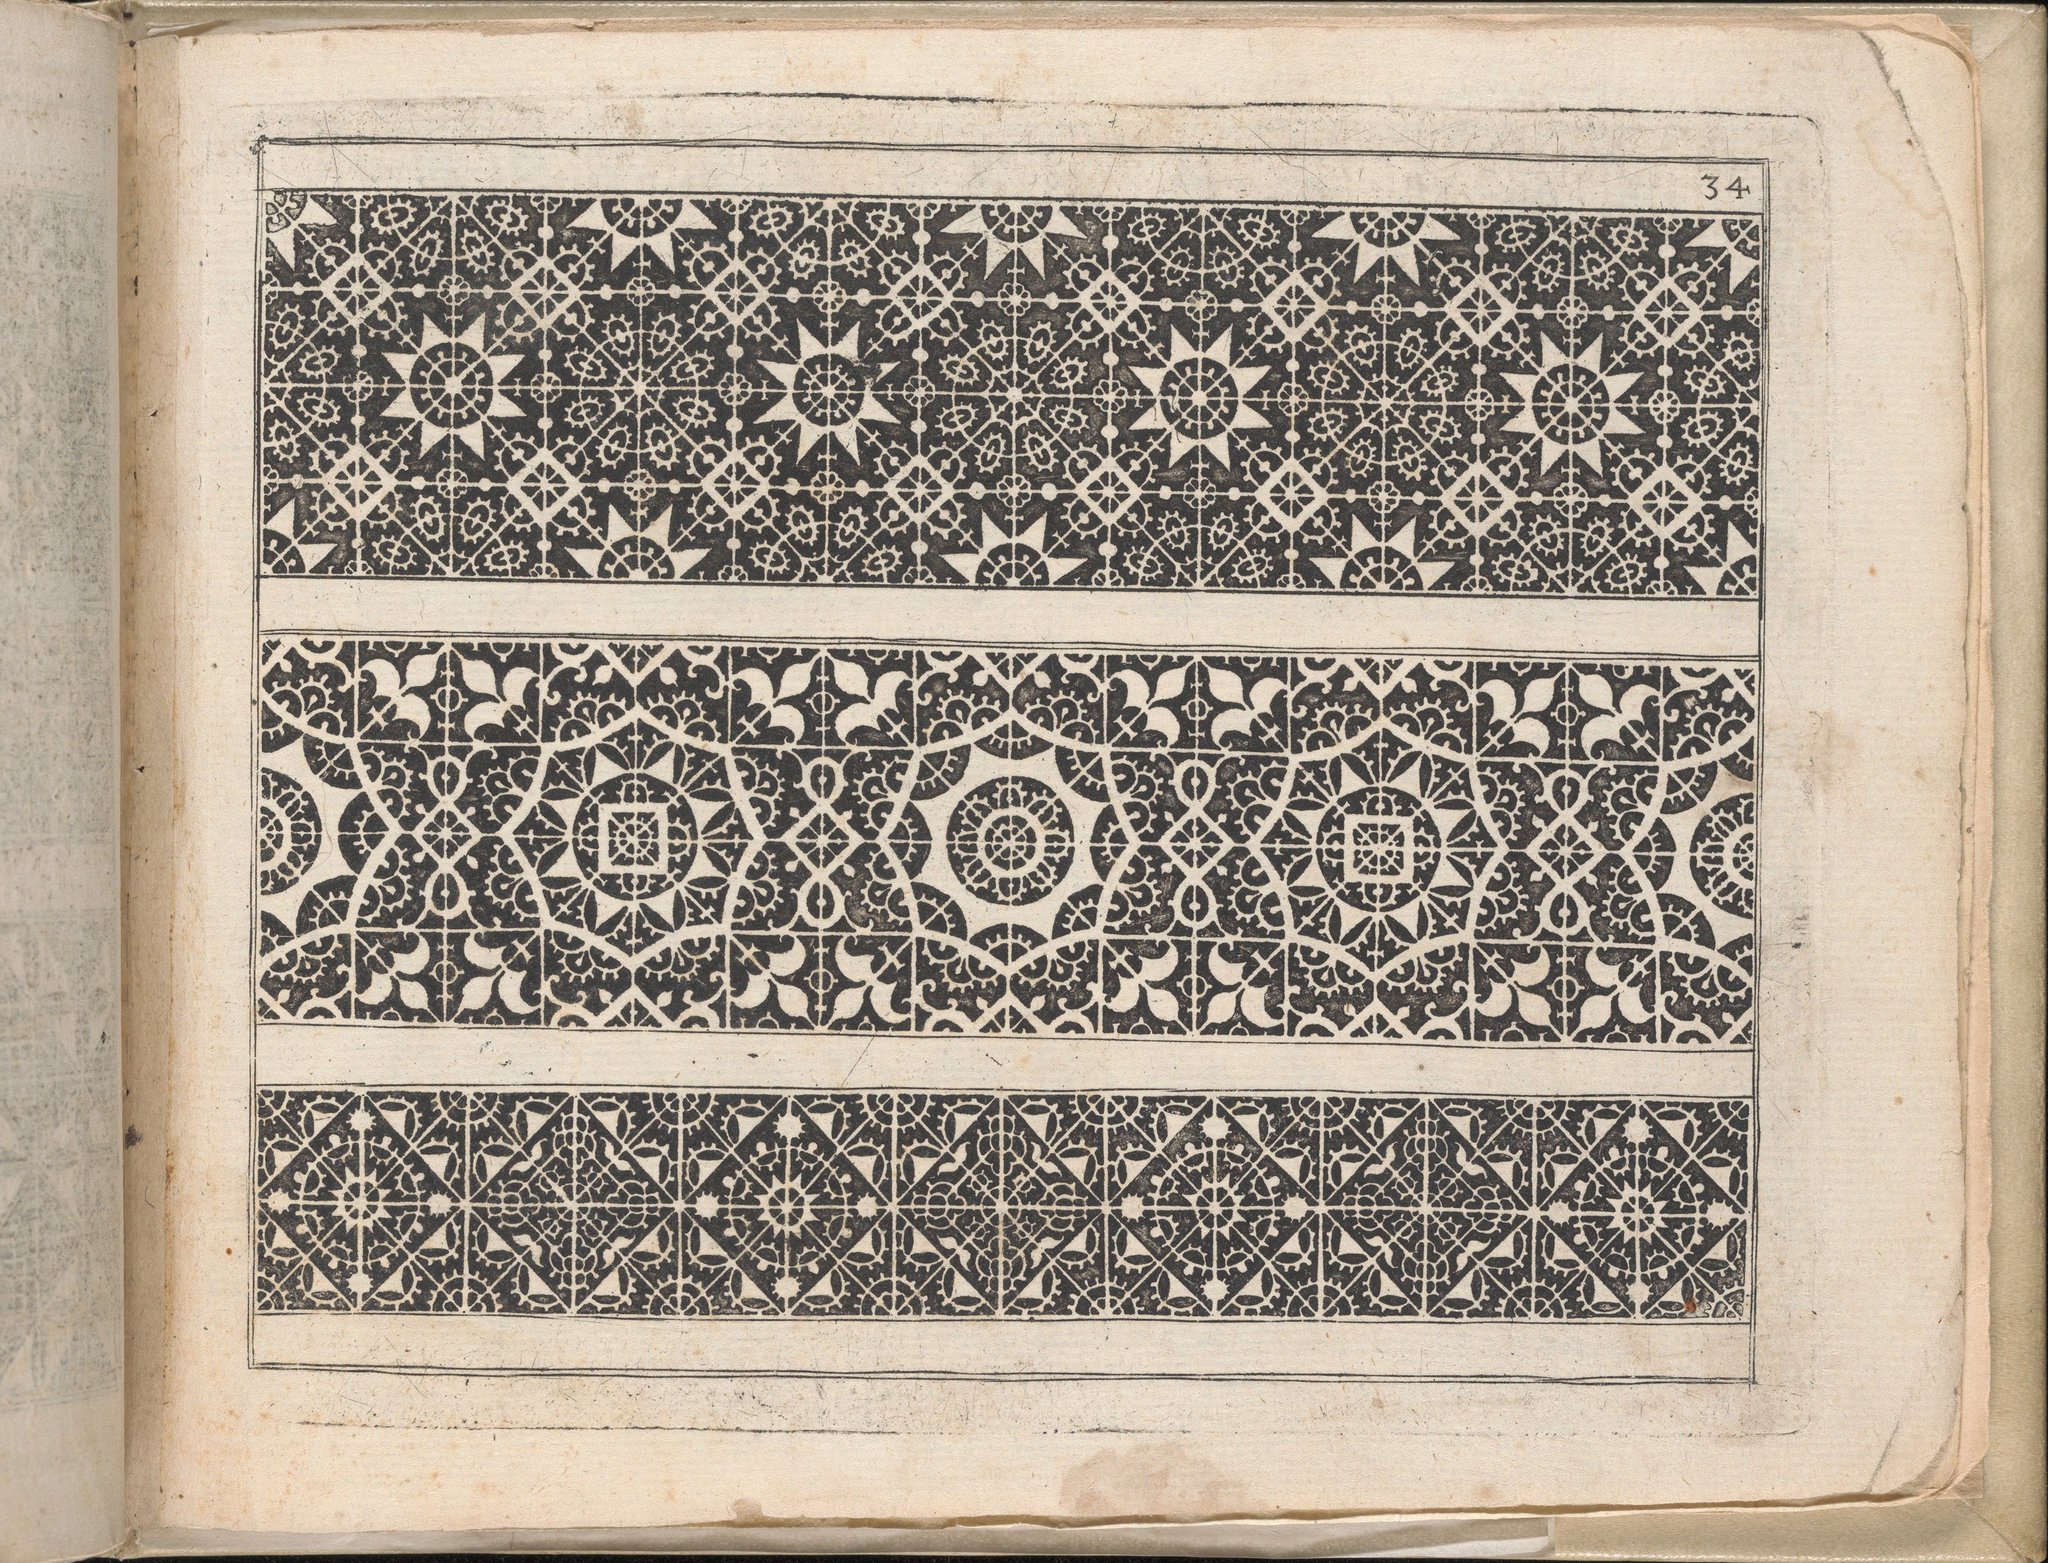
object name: book print ornament architecture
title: Schön Neues Modelbuch (Page 39 recto)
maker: johann sibmacher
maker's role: designer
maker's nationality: german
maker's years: 1590-1611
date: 1597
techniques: etching